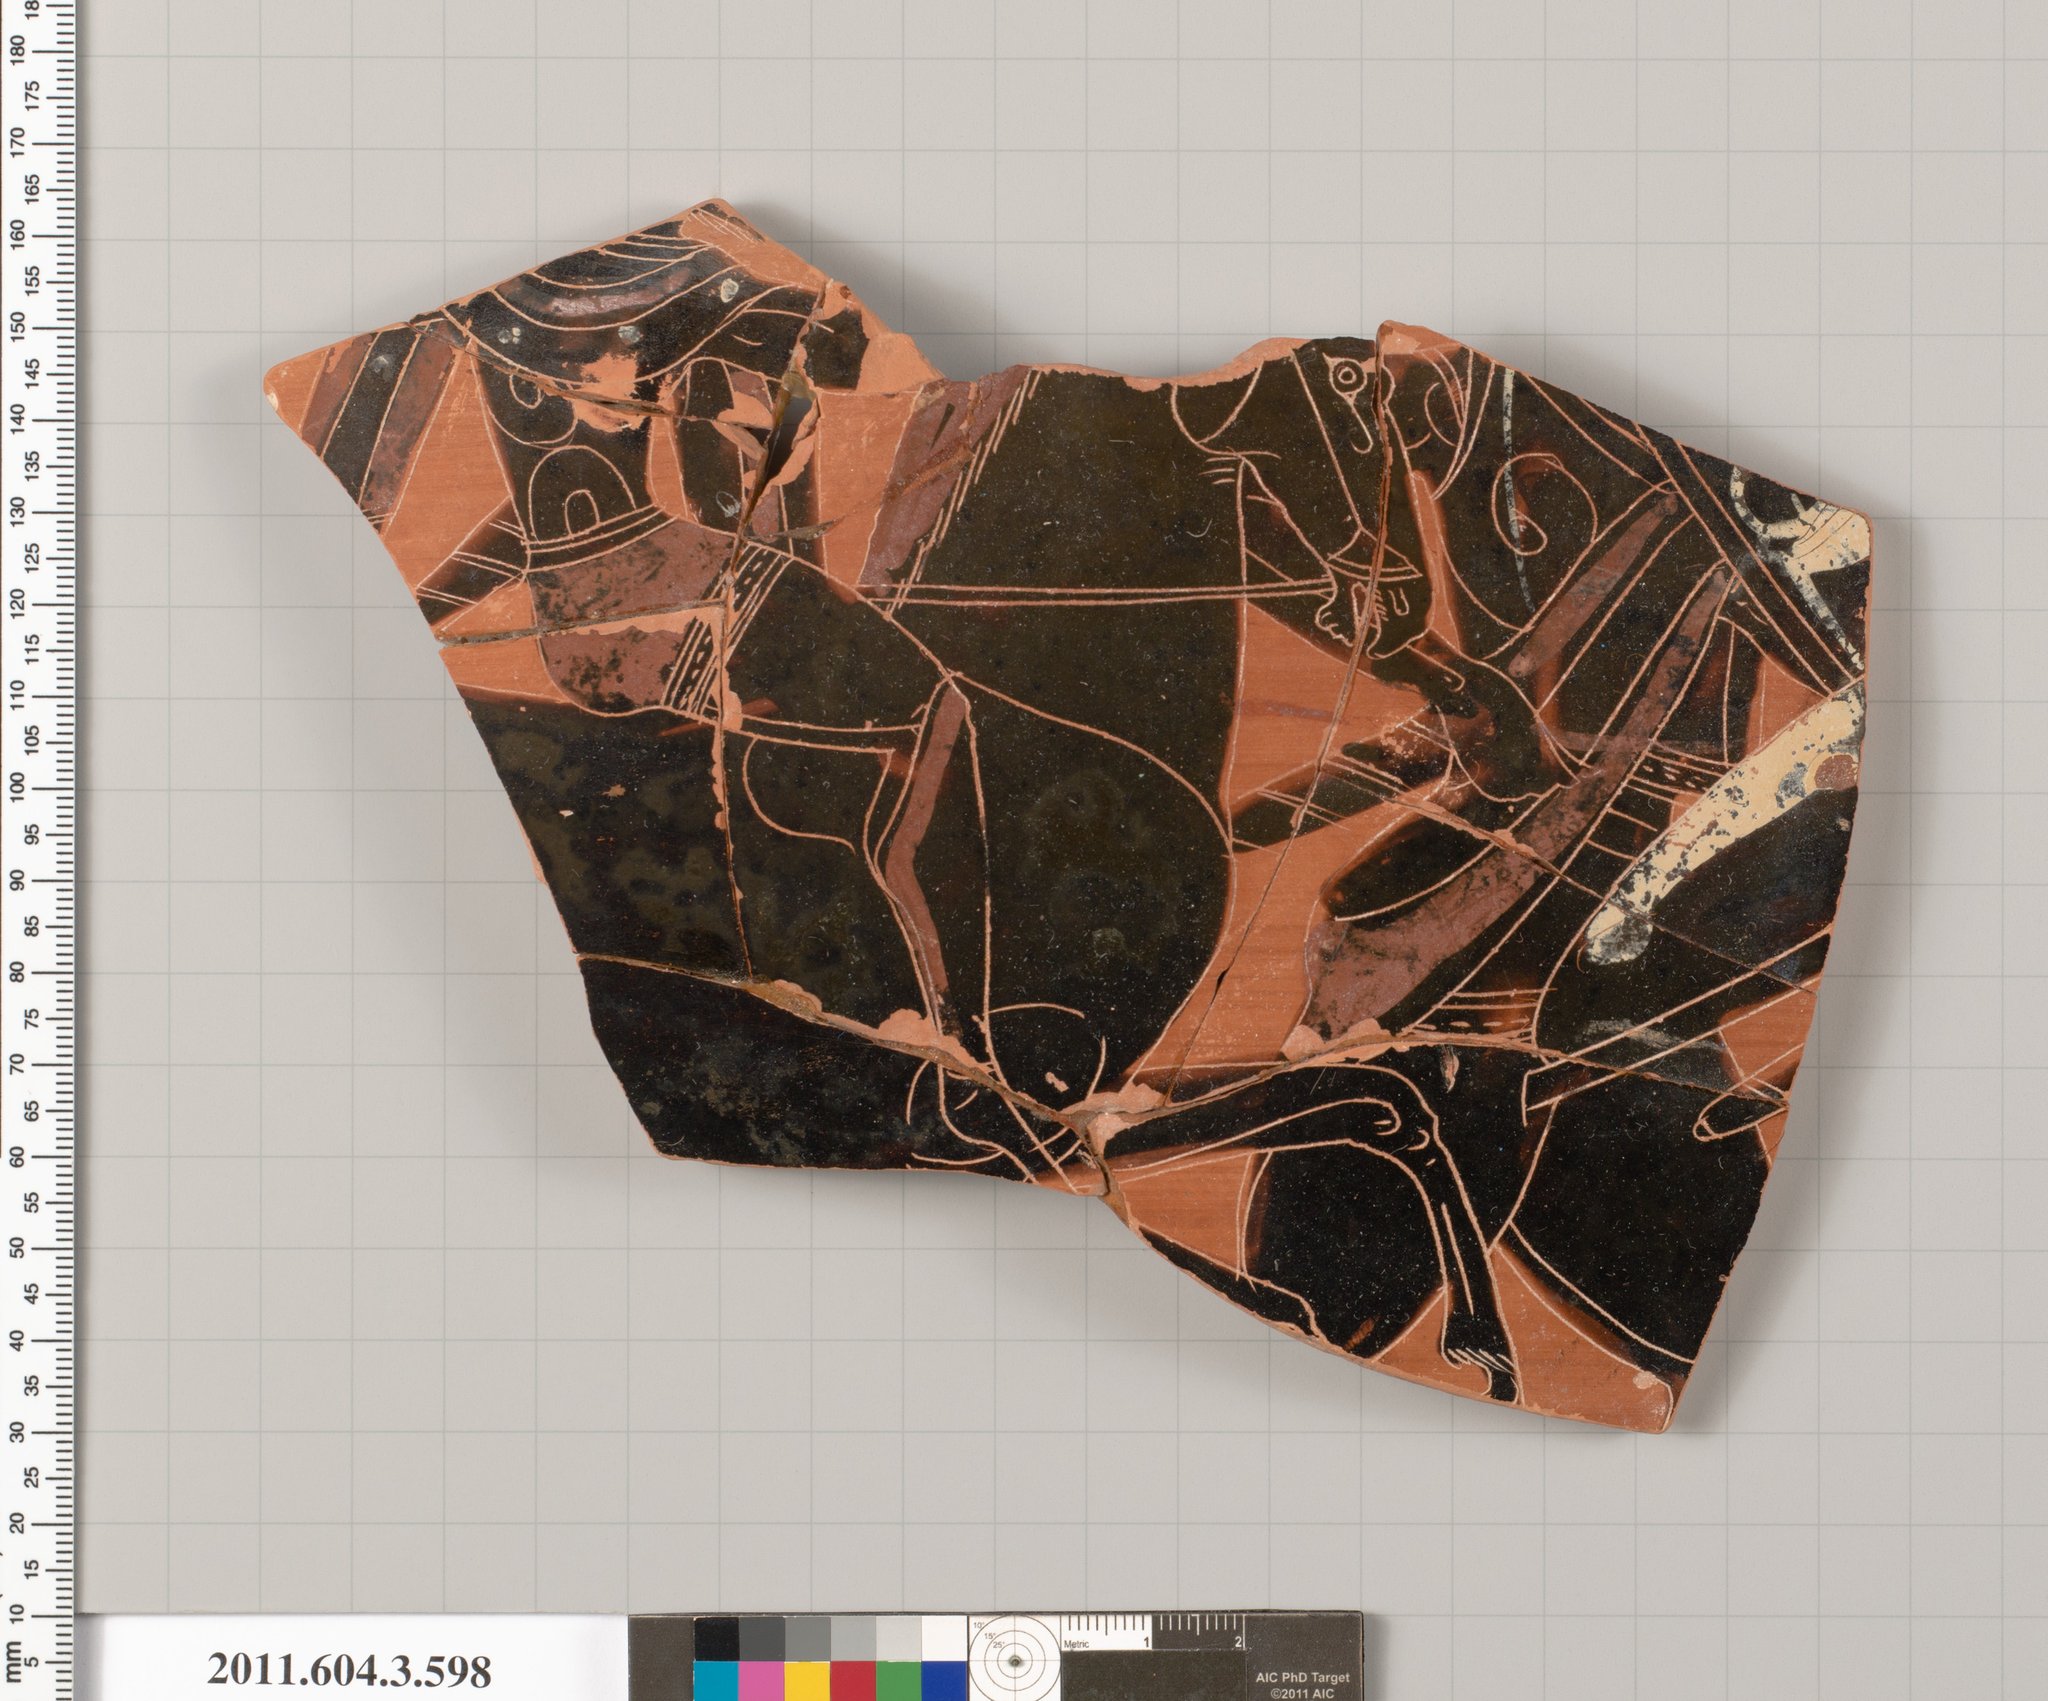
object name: column krater fragment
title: Terracotta fragment of a column-krater (bowl for mixing wine and water)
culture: greek, attic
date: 540-530 BCE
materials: terracotta